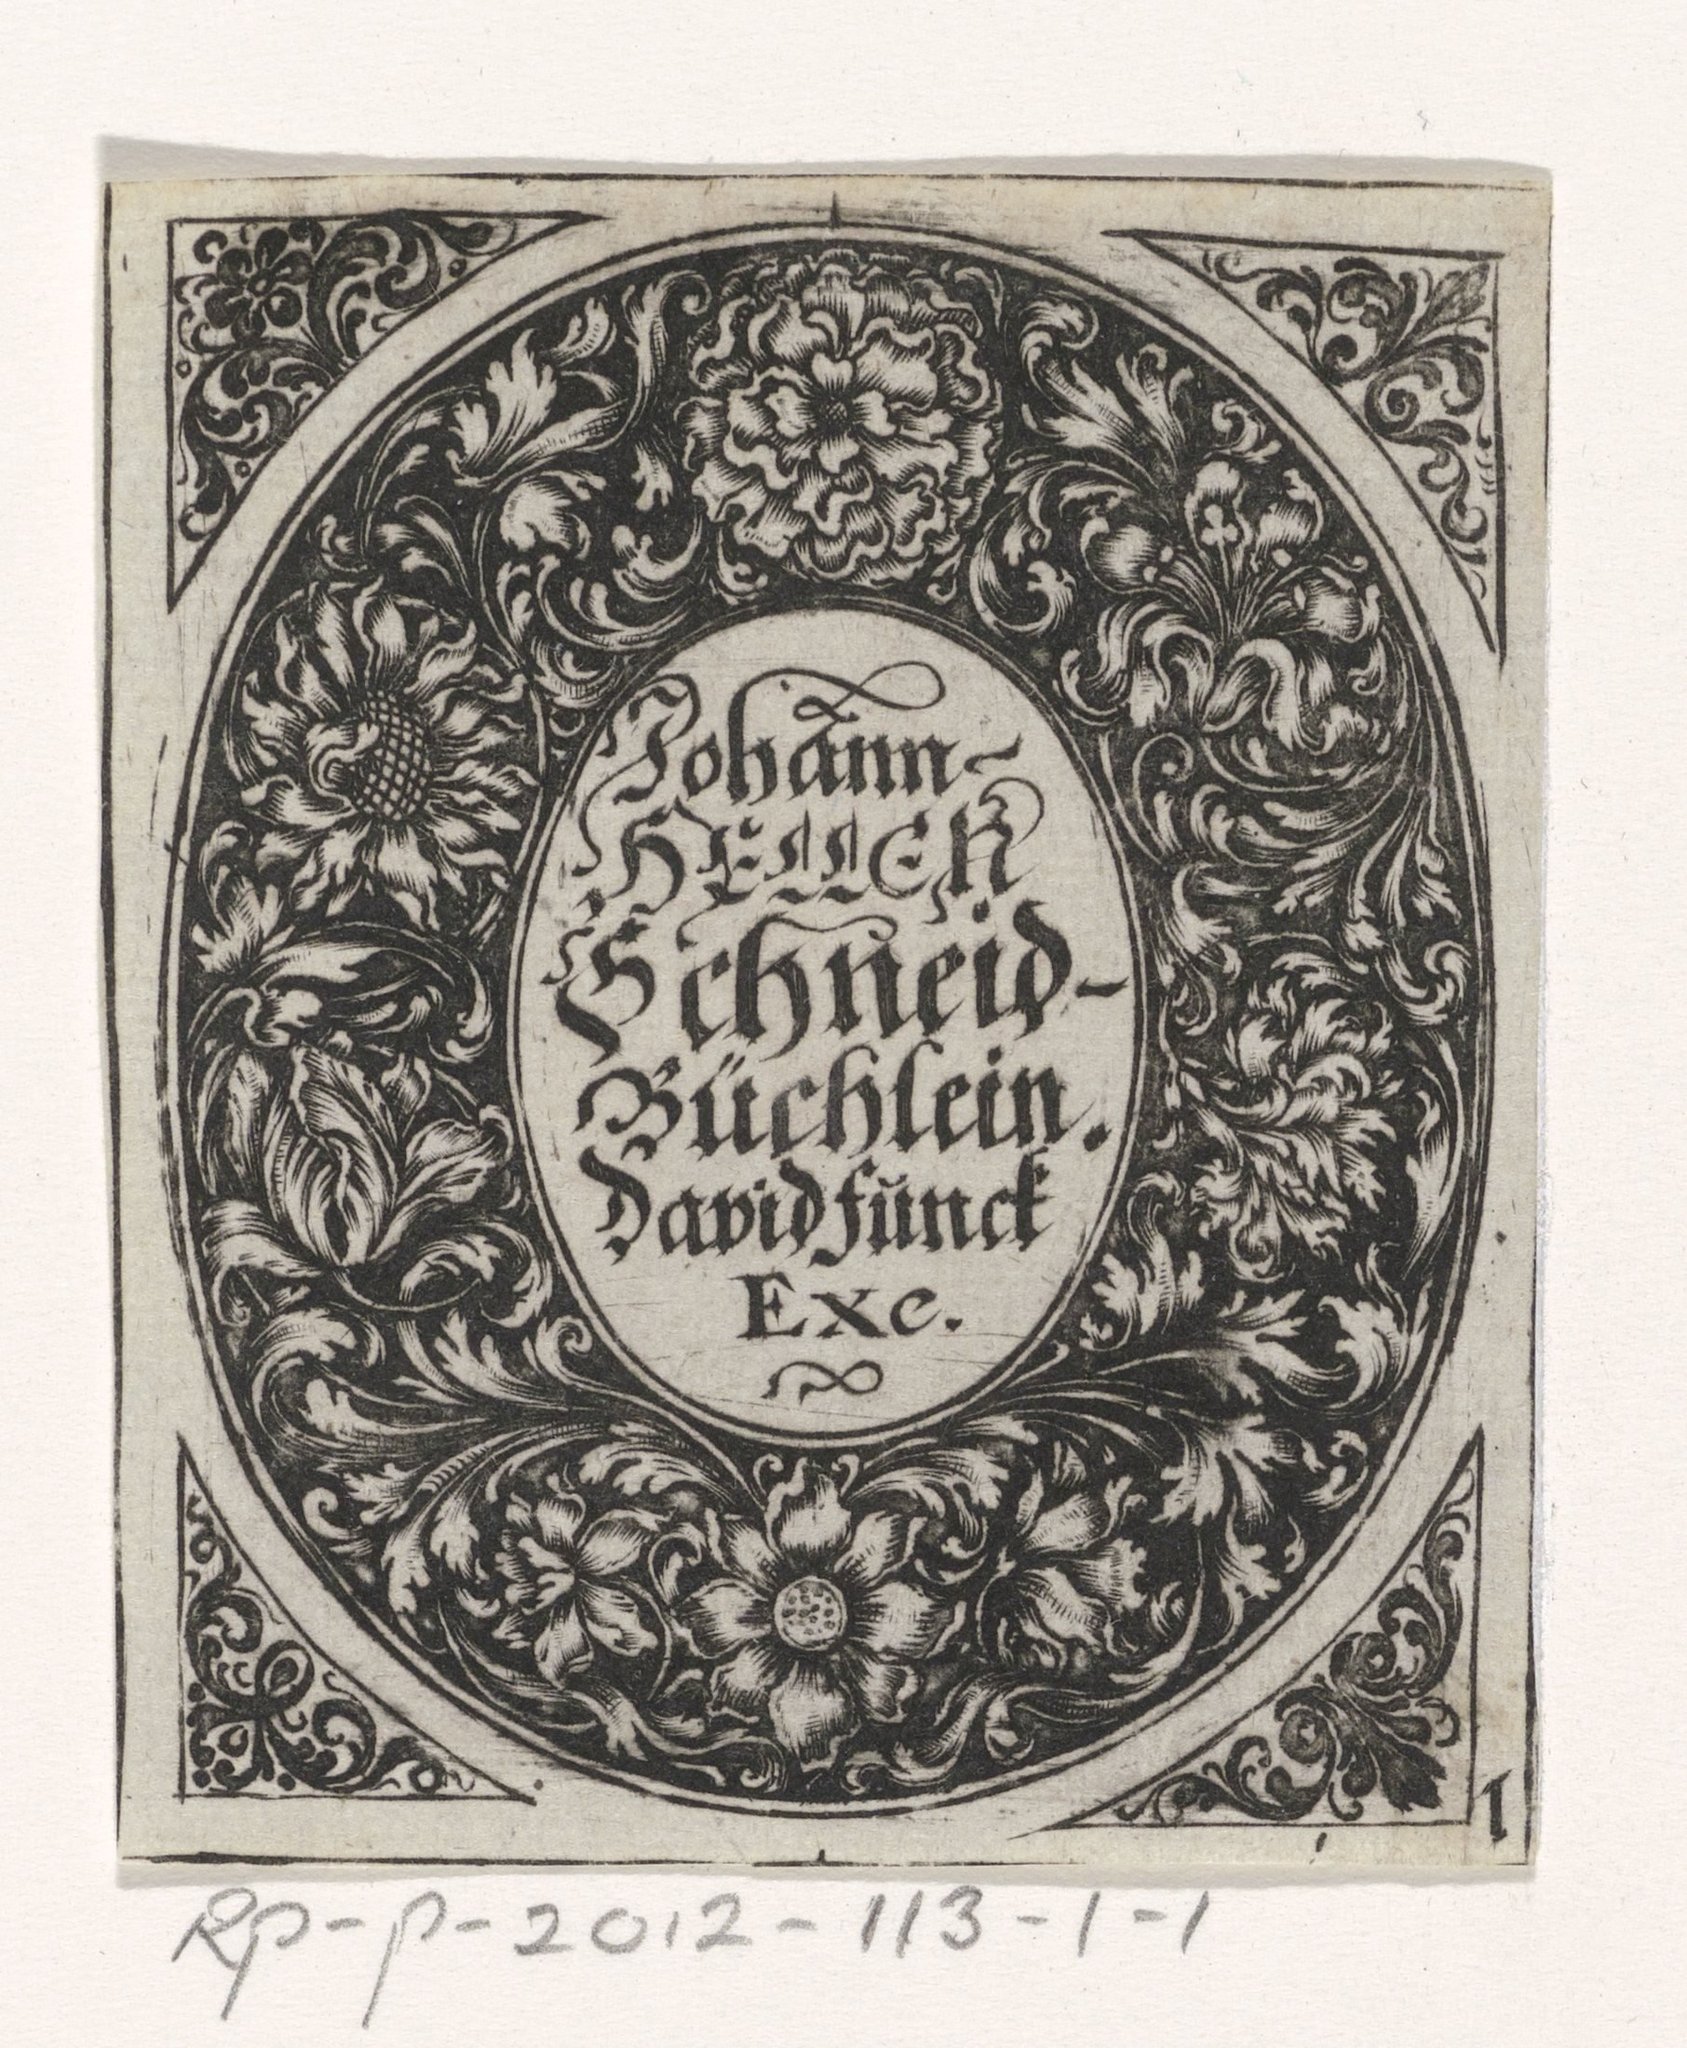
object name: ornament print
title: Serie van zes ornamenten voor goudsmeden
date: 1647-1709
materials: paper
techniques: engraving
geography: nuremberg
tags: ornament derived from plant forms